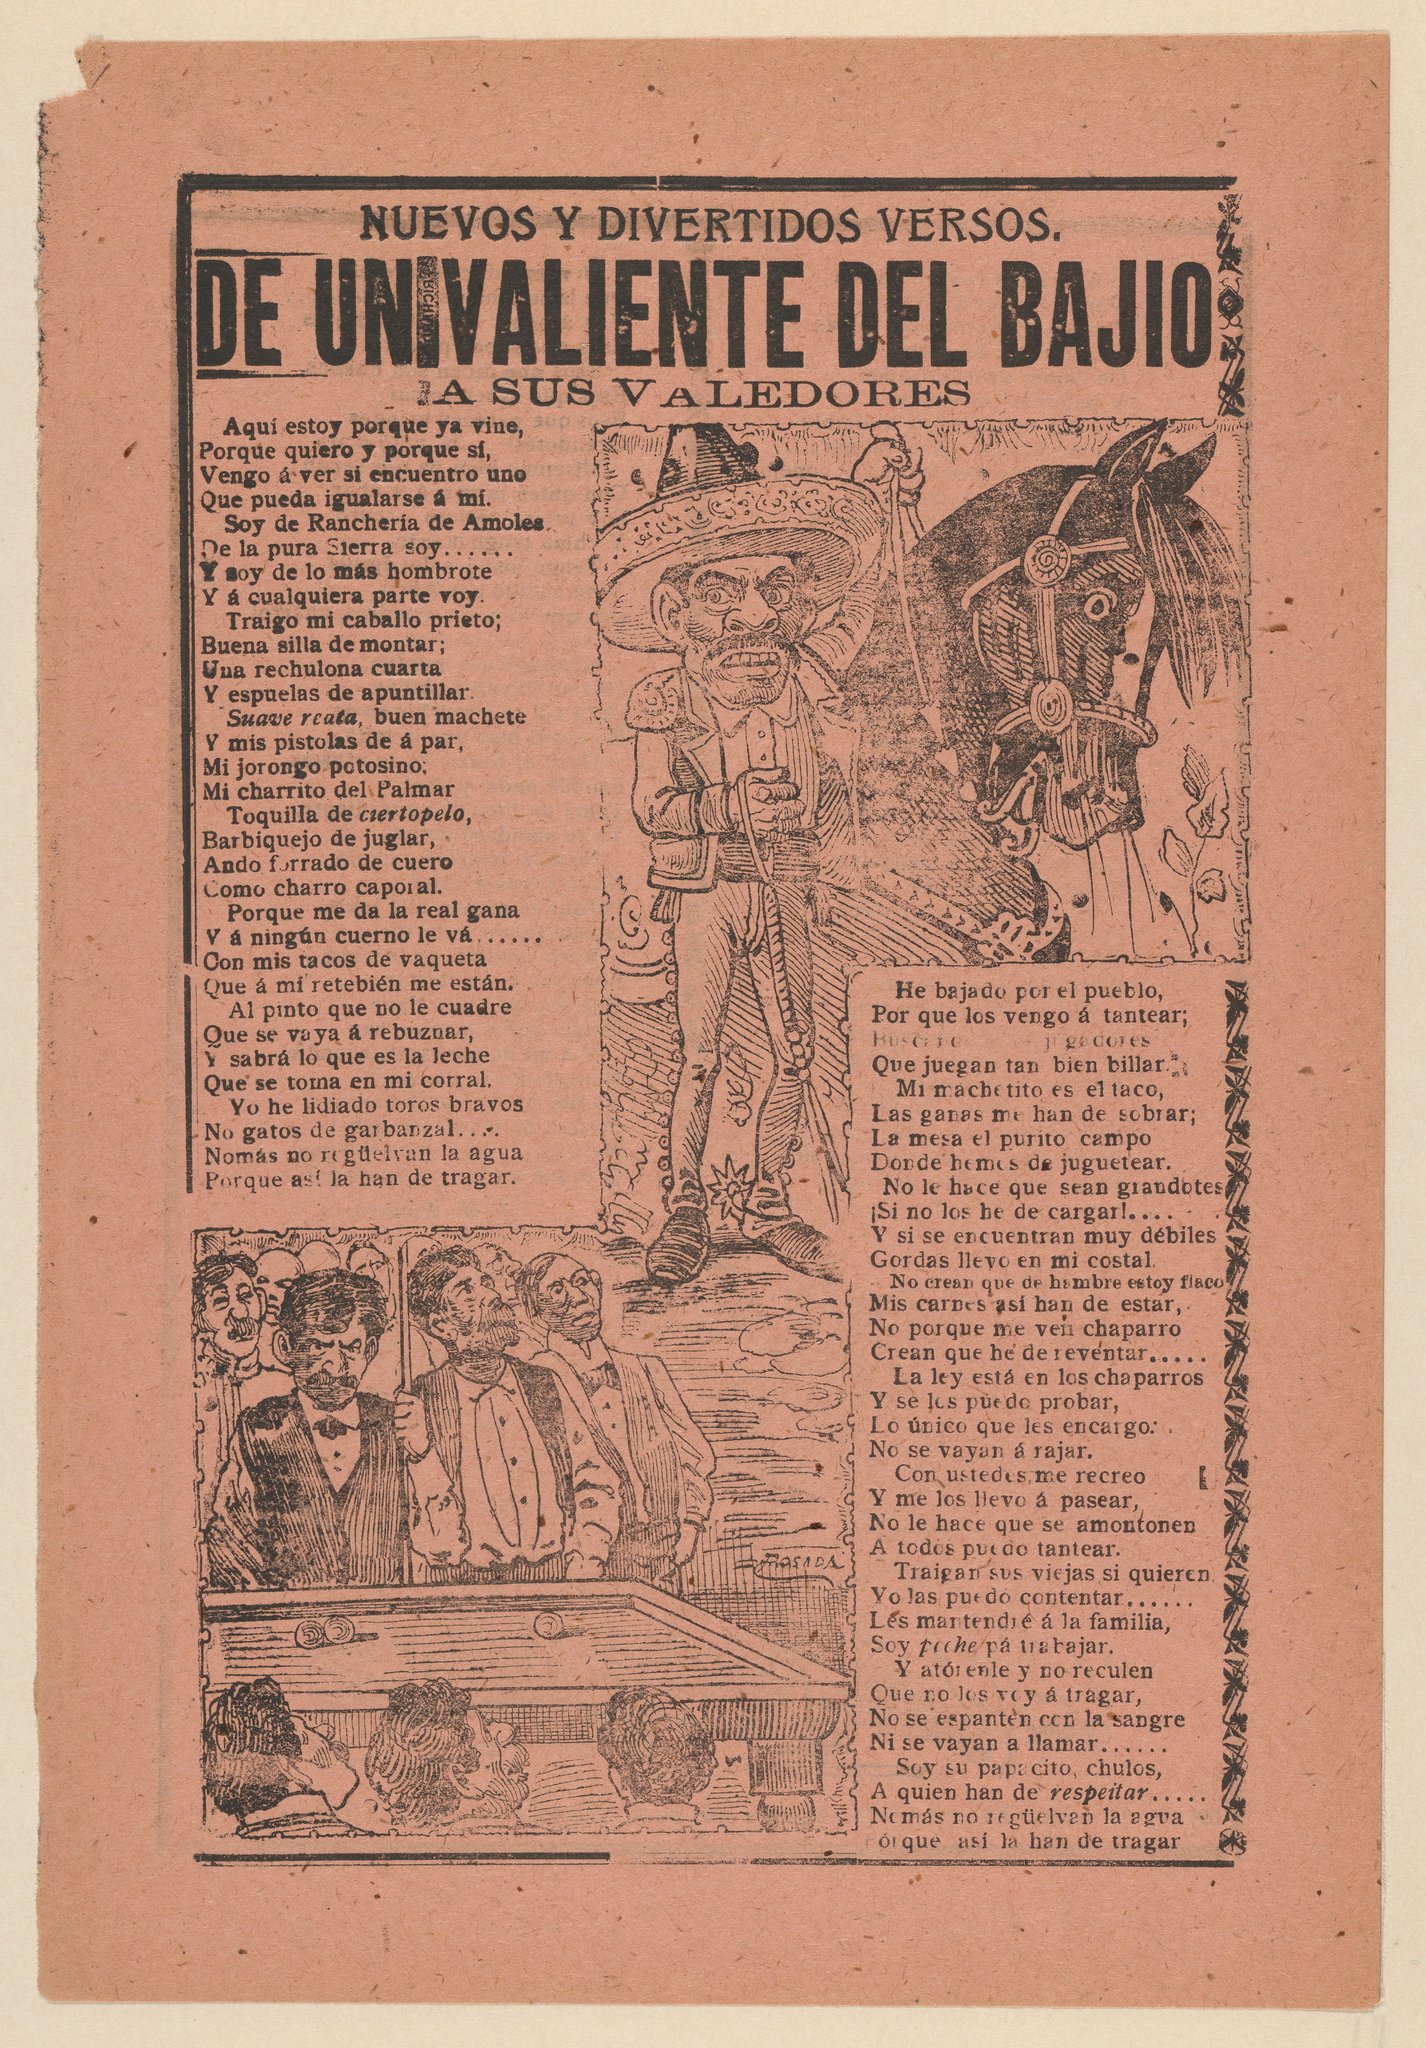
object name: print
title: Broadsheet with new and entertaining verses about a 'Brave Man from the Heartland to His Friends' a caricature of a horseman and his horse and a group of men playing billiards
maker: josé guadalupe posada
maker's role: artist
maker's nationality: mexican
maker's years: 1852-1913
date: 1902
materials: paper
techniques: letterpress, lithography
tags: men,horses